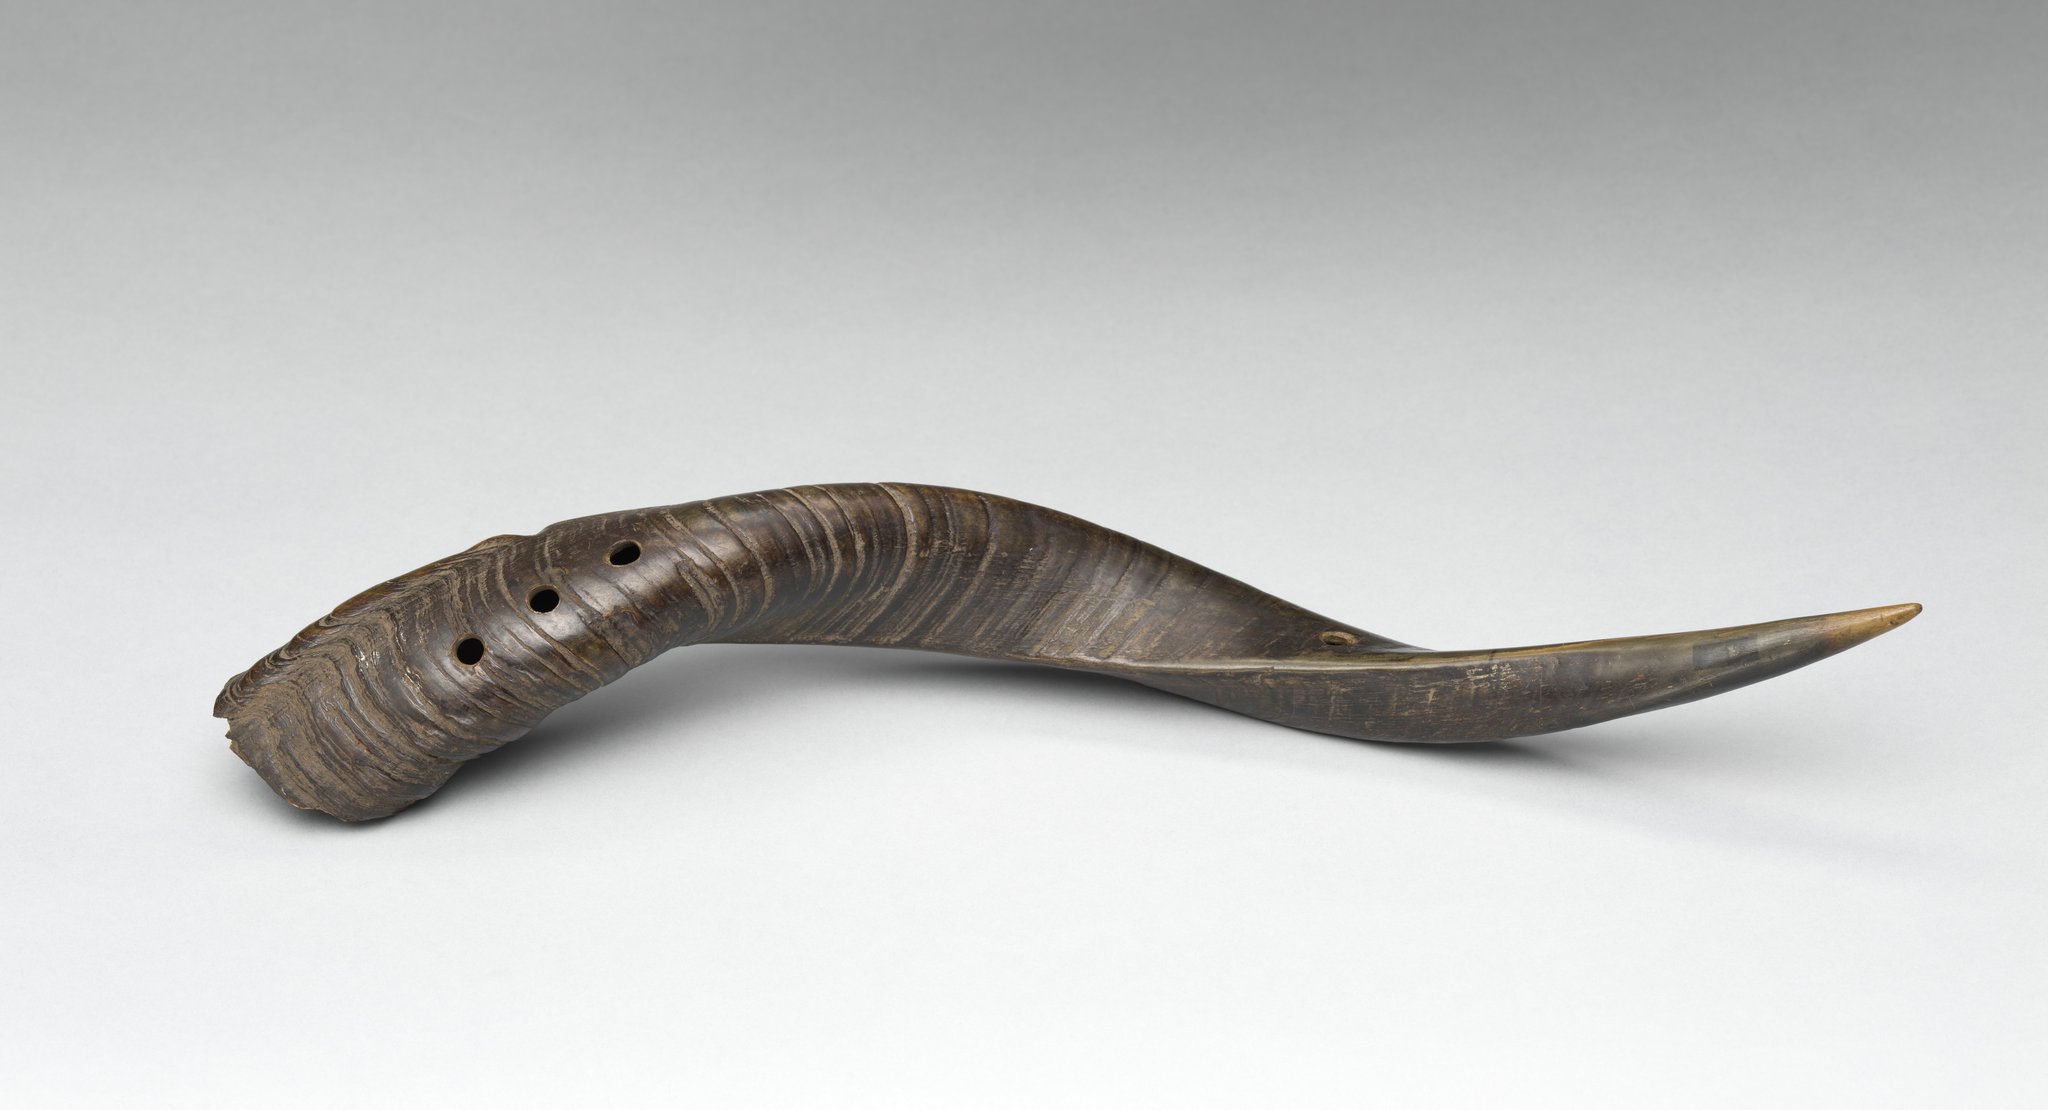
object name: horn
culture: african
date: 1867-1900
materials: horn